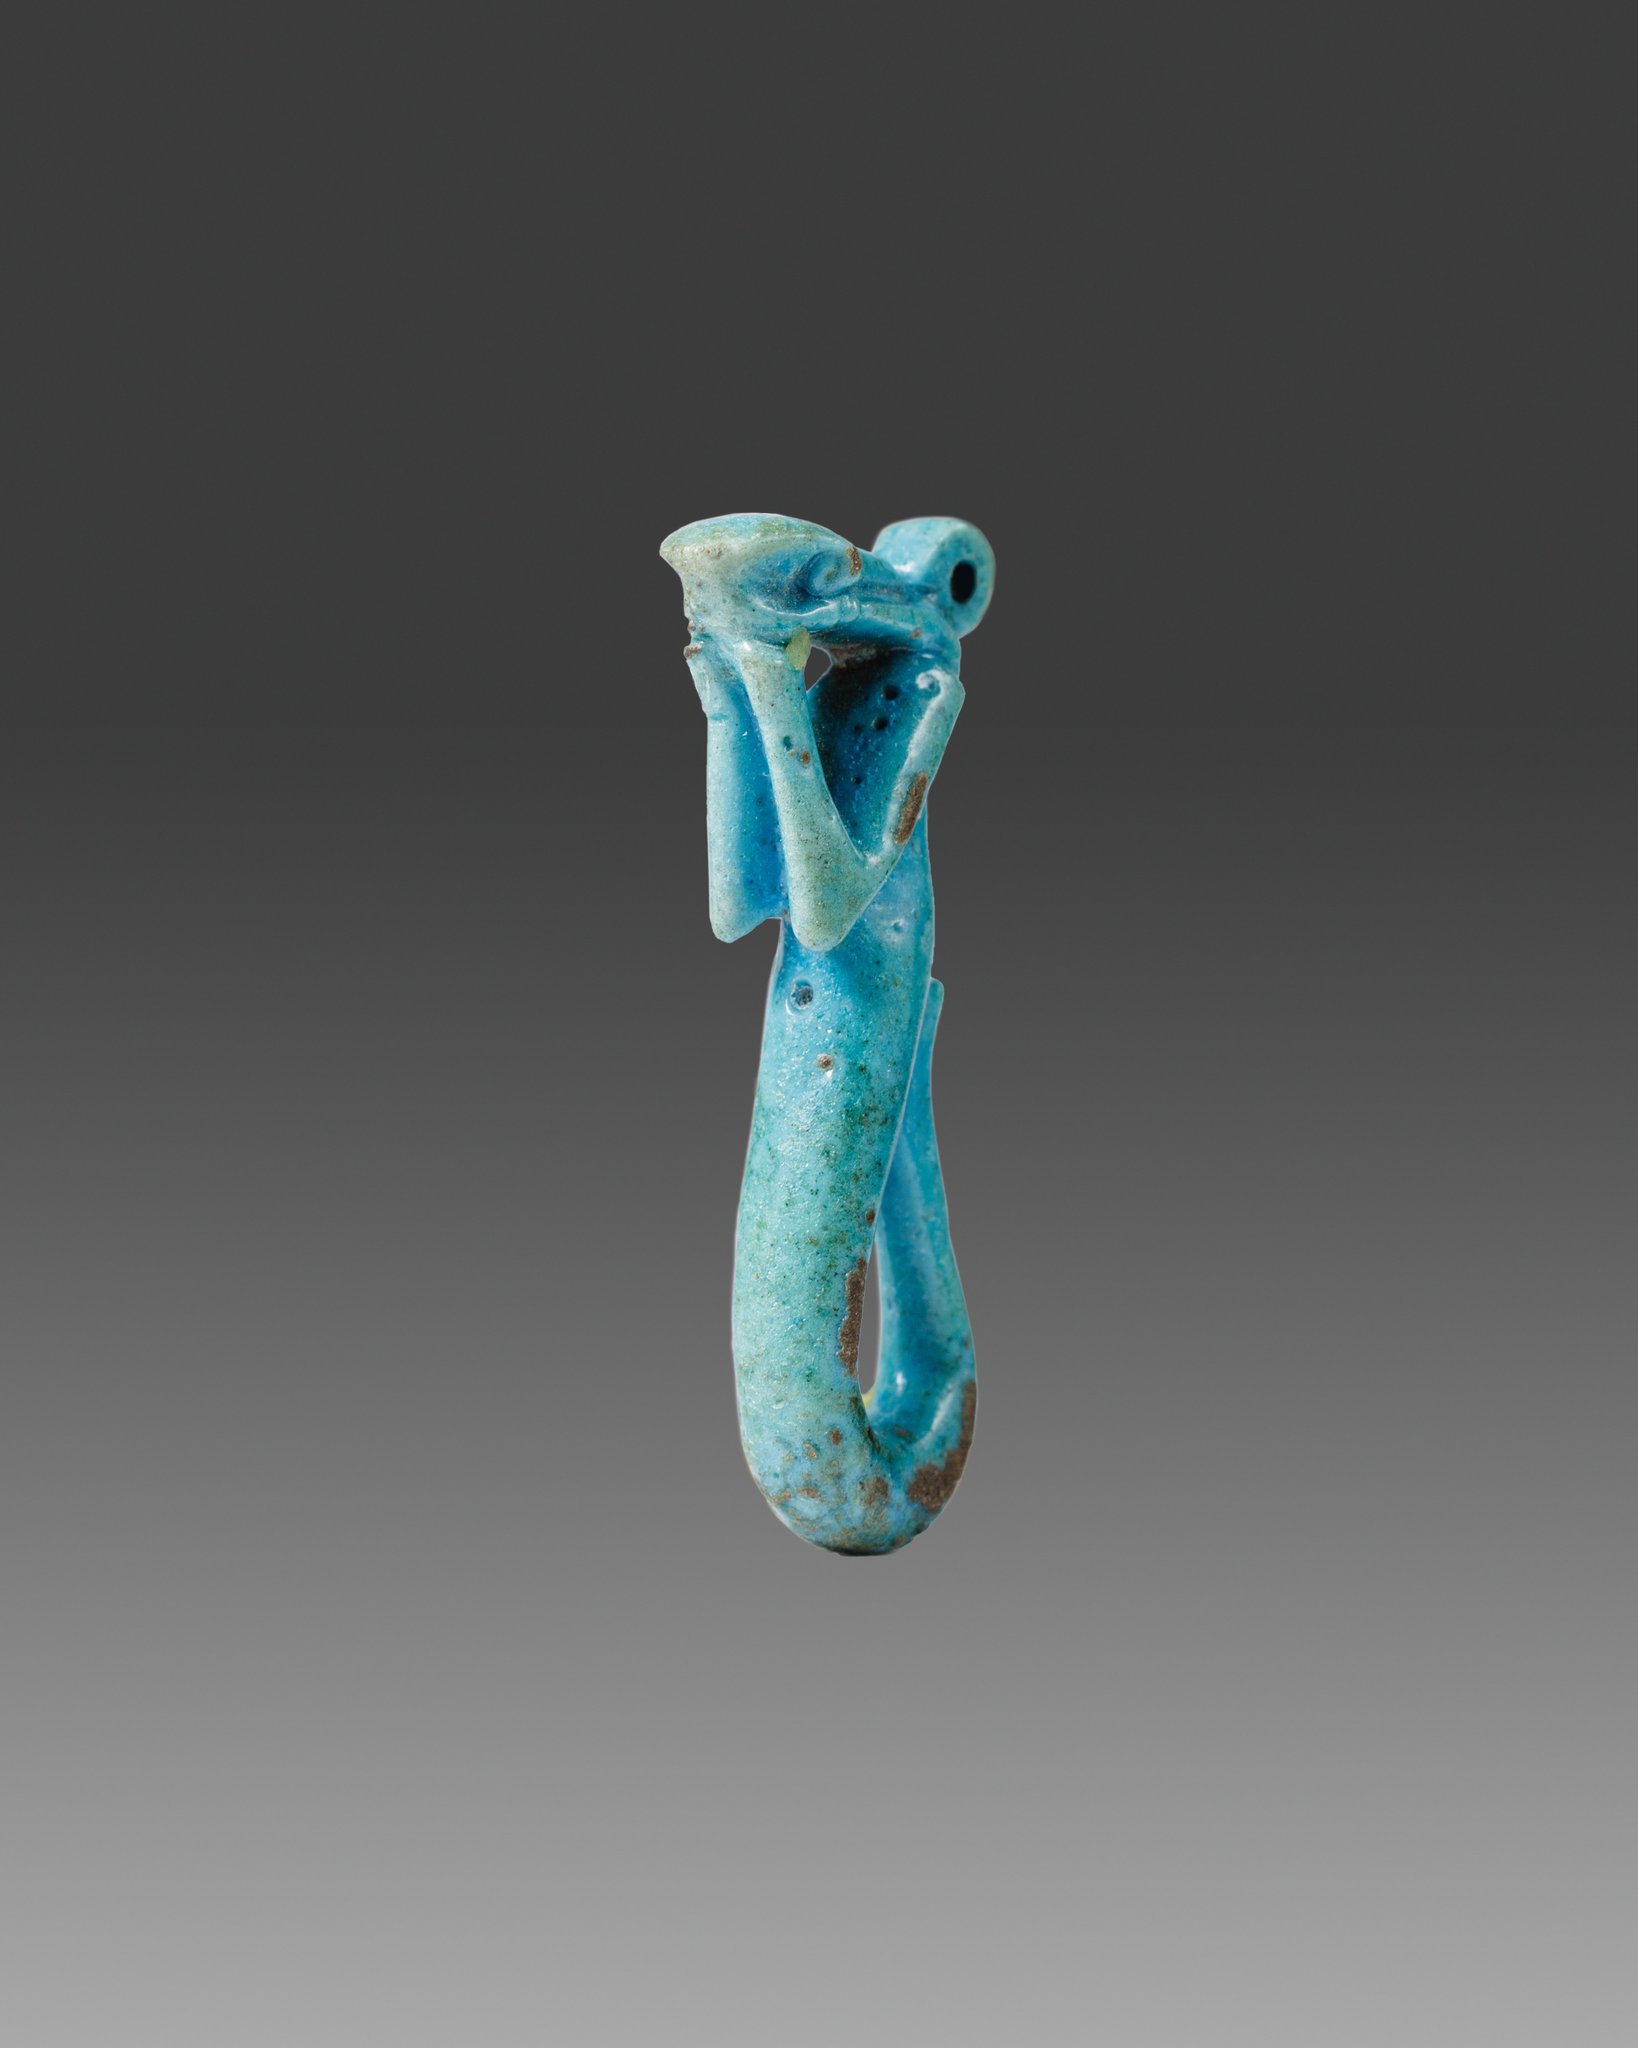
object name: amulet, nehebkau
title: Amulet in the form of a serpent decan with raised arms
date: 664-630 BCE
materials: faience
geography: egypt